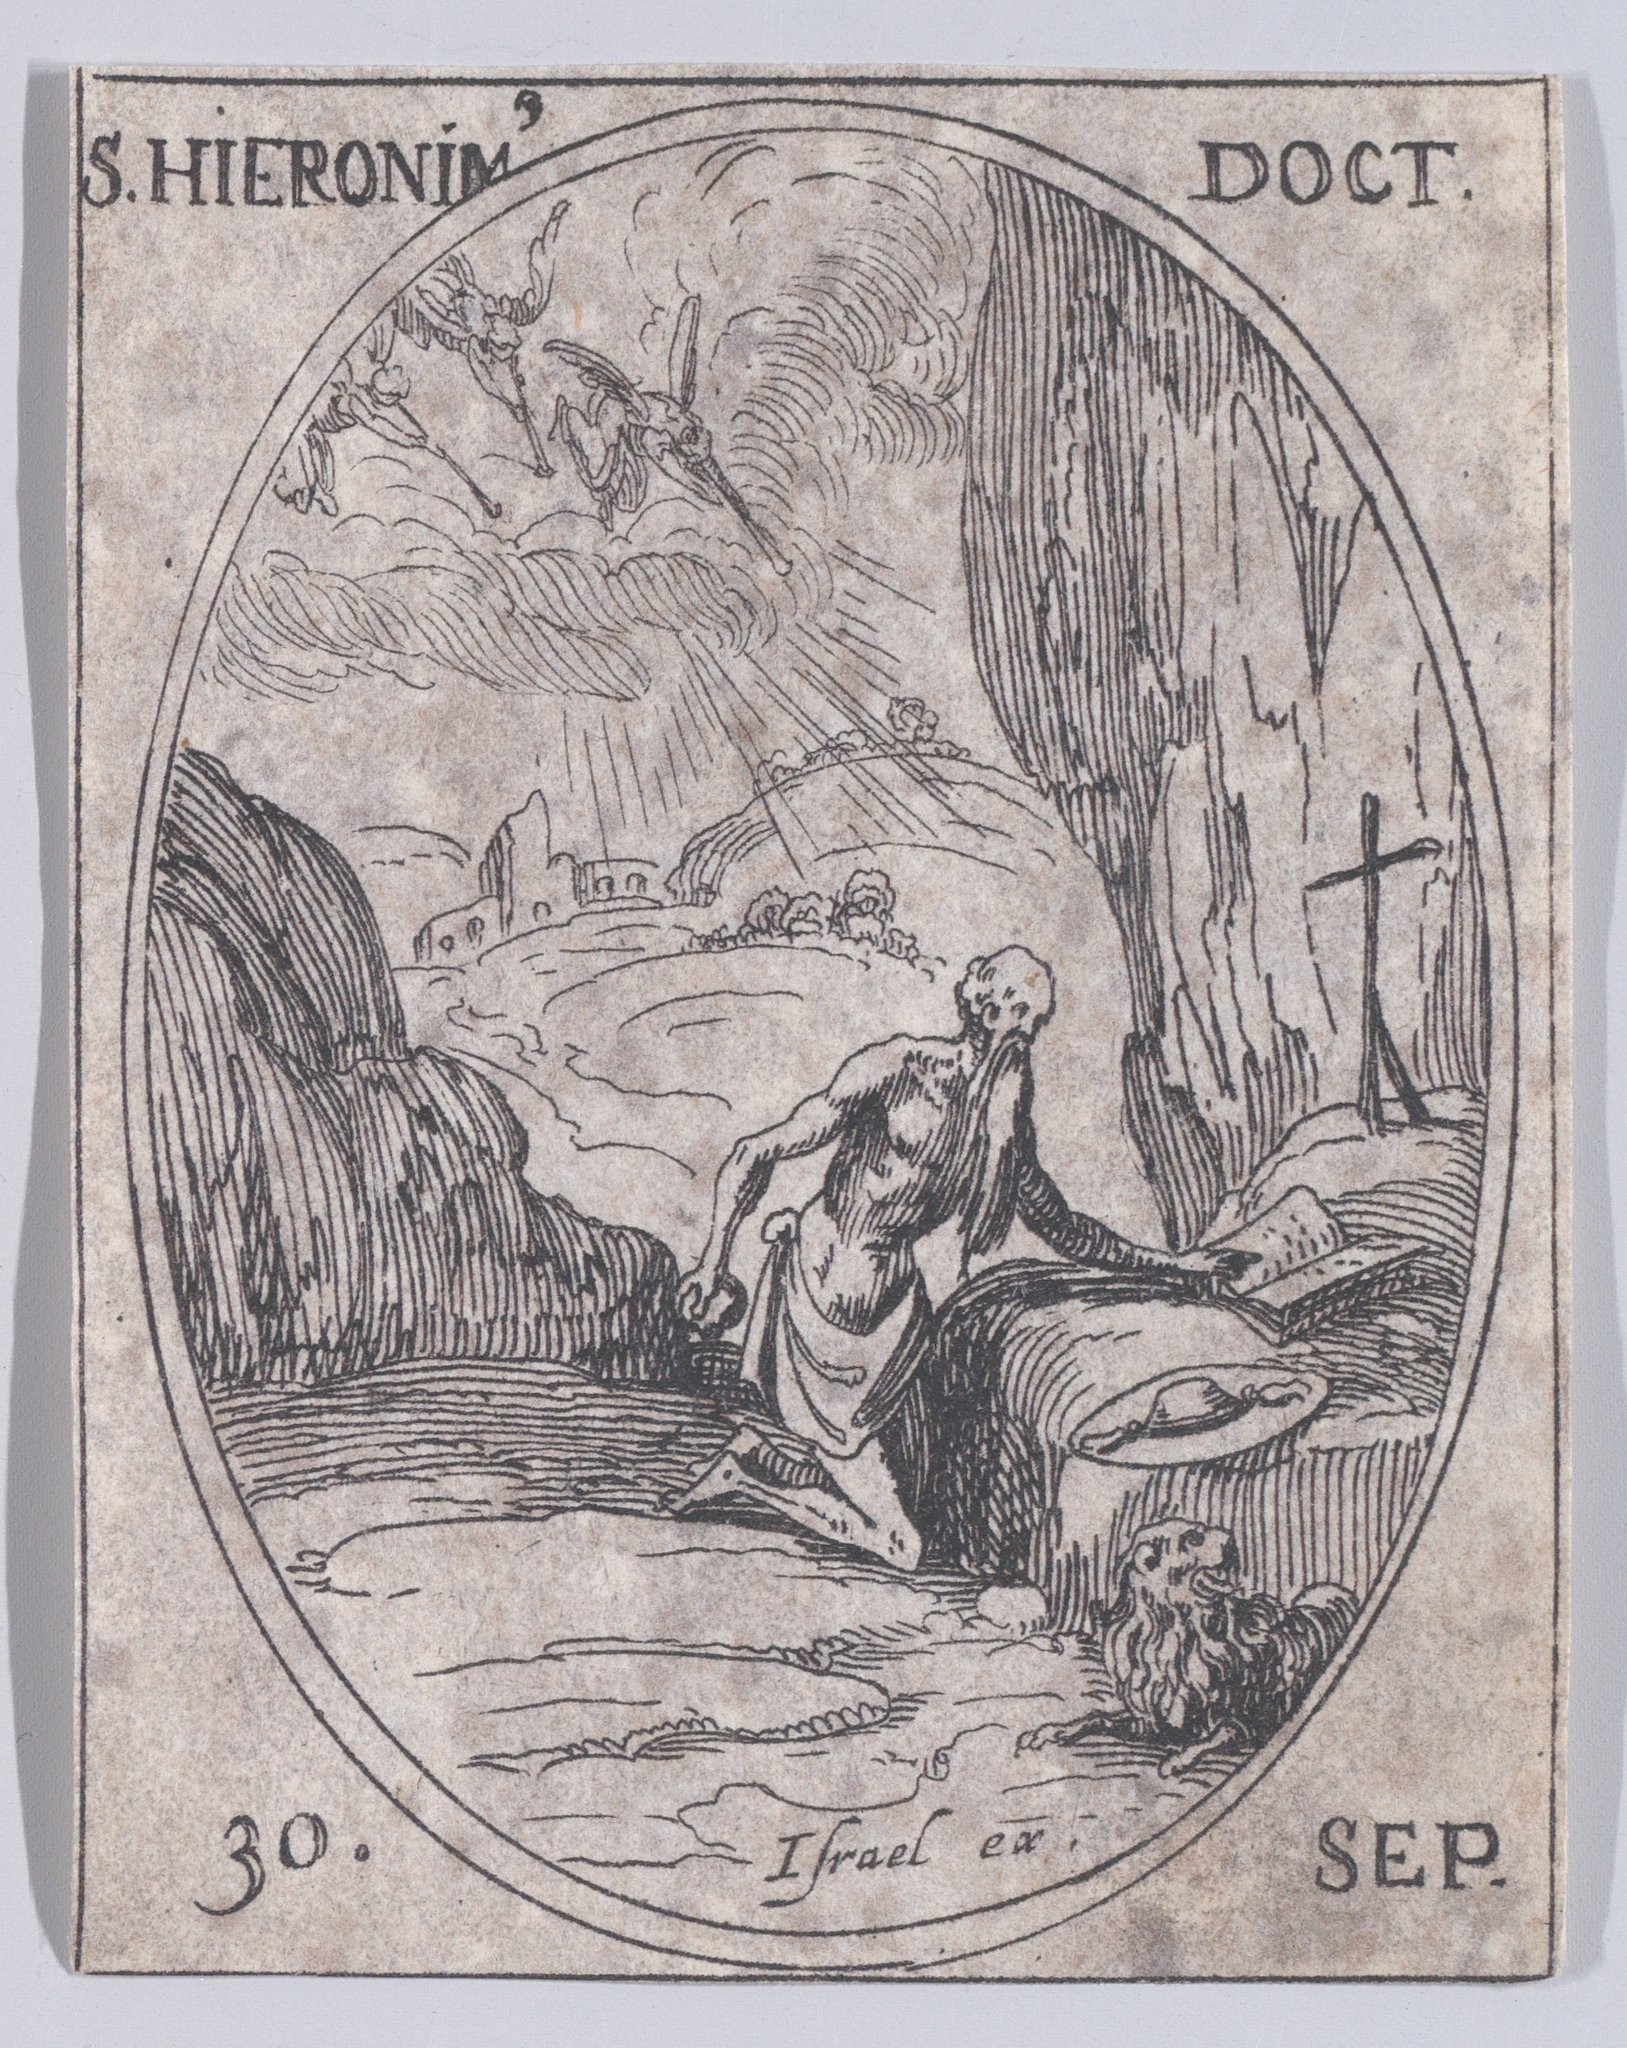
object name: print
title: S. Jérôme, docteur (St. Jerome, Doctor), September 30th, from "Les Images De Tous Les Saincts et Saintes de L'Année" (Images of All of the Saints and Religious Events of the Year)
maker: jacques callot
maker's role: artist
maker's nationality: french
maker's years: 1592-1635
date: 1636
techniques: etching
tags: men,saint jerome